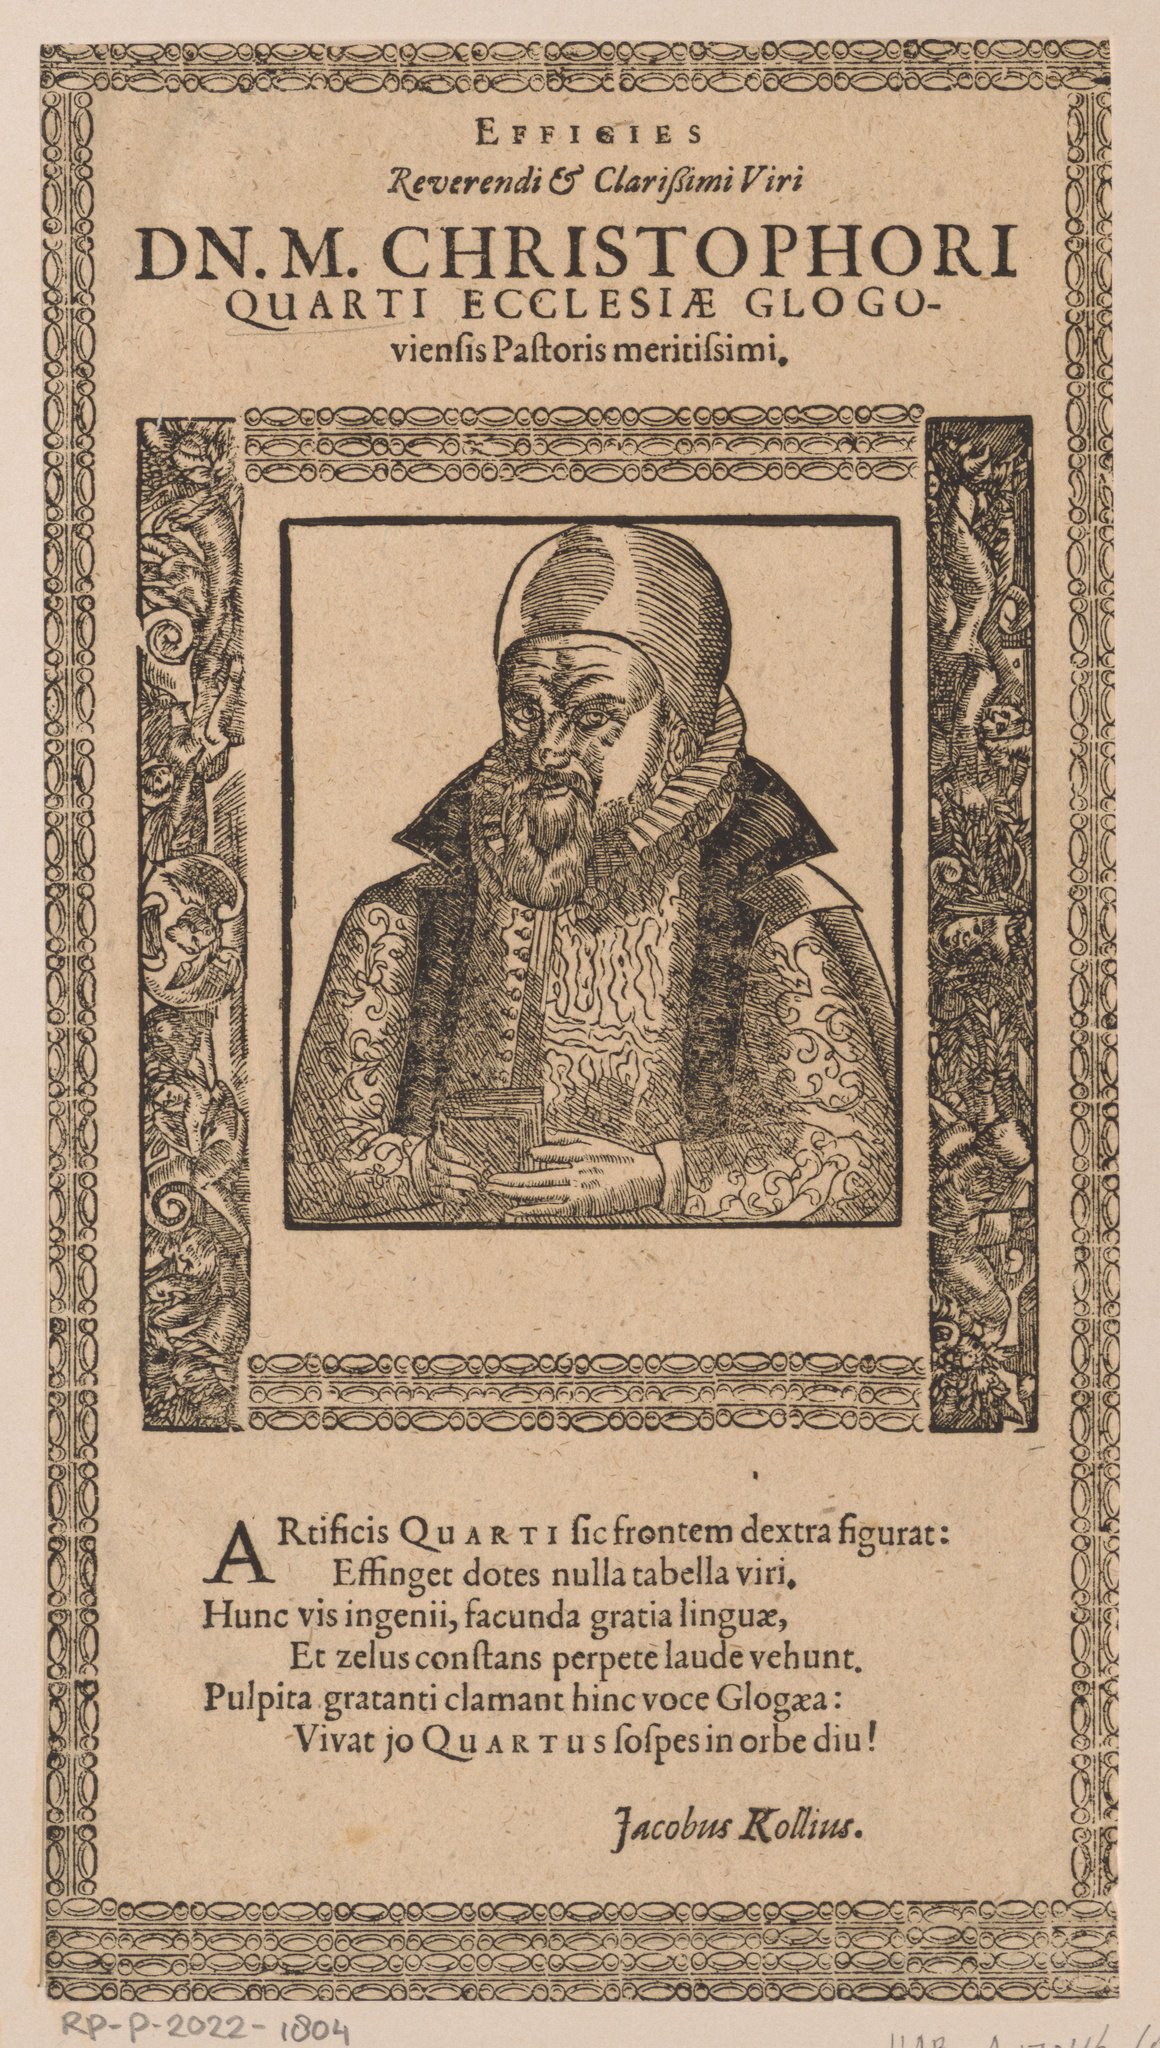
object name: print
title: Portret van Christoph Quartus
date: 1598-1650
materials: paper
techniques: letterpress printing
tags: historical persons, organization, functionaries and dignitaries in roman catholic church; clergy in general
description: Met zesregelig onderschrift in het Latijn.